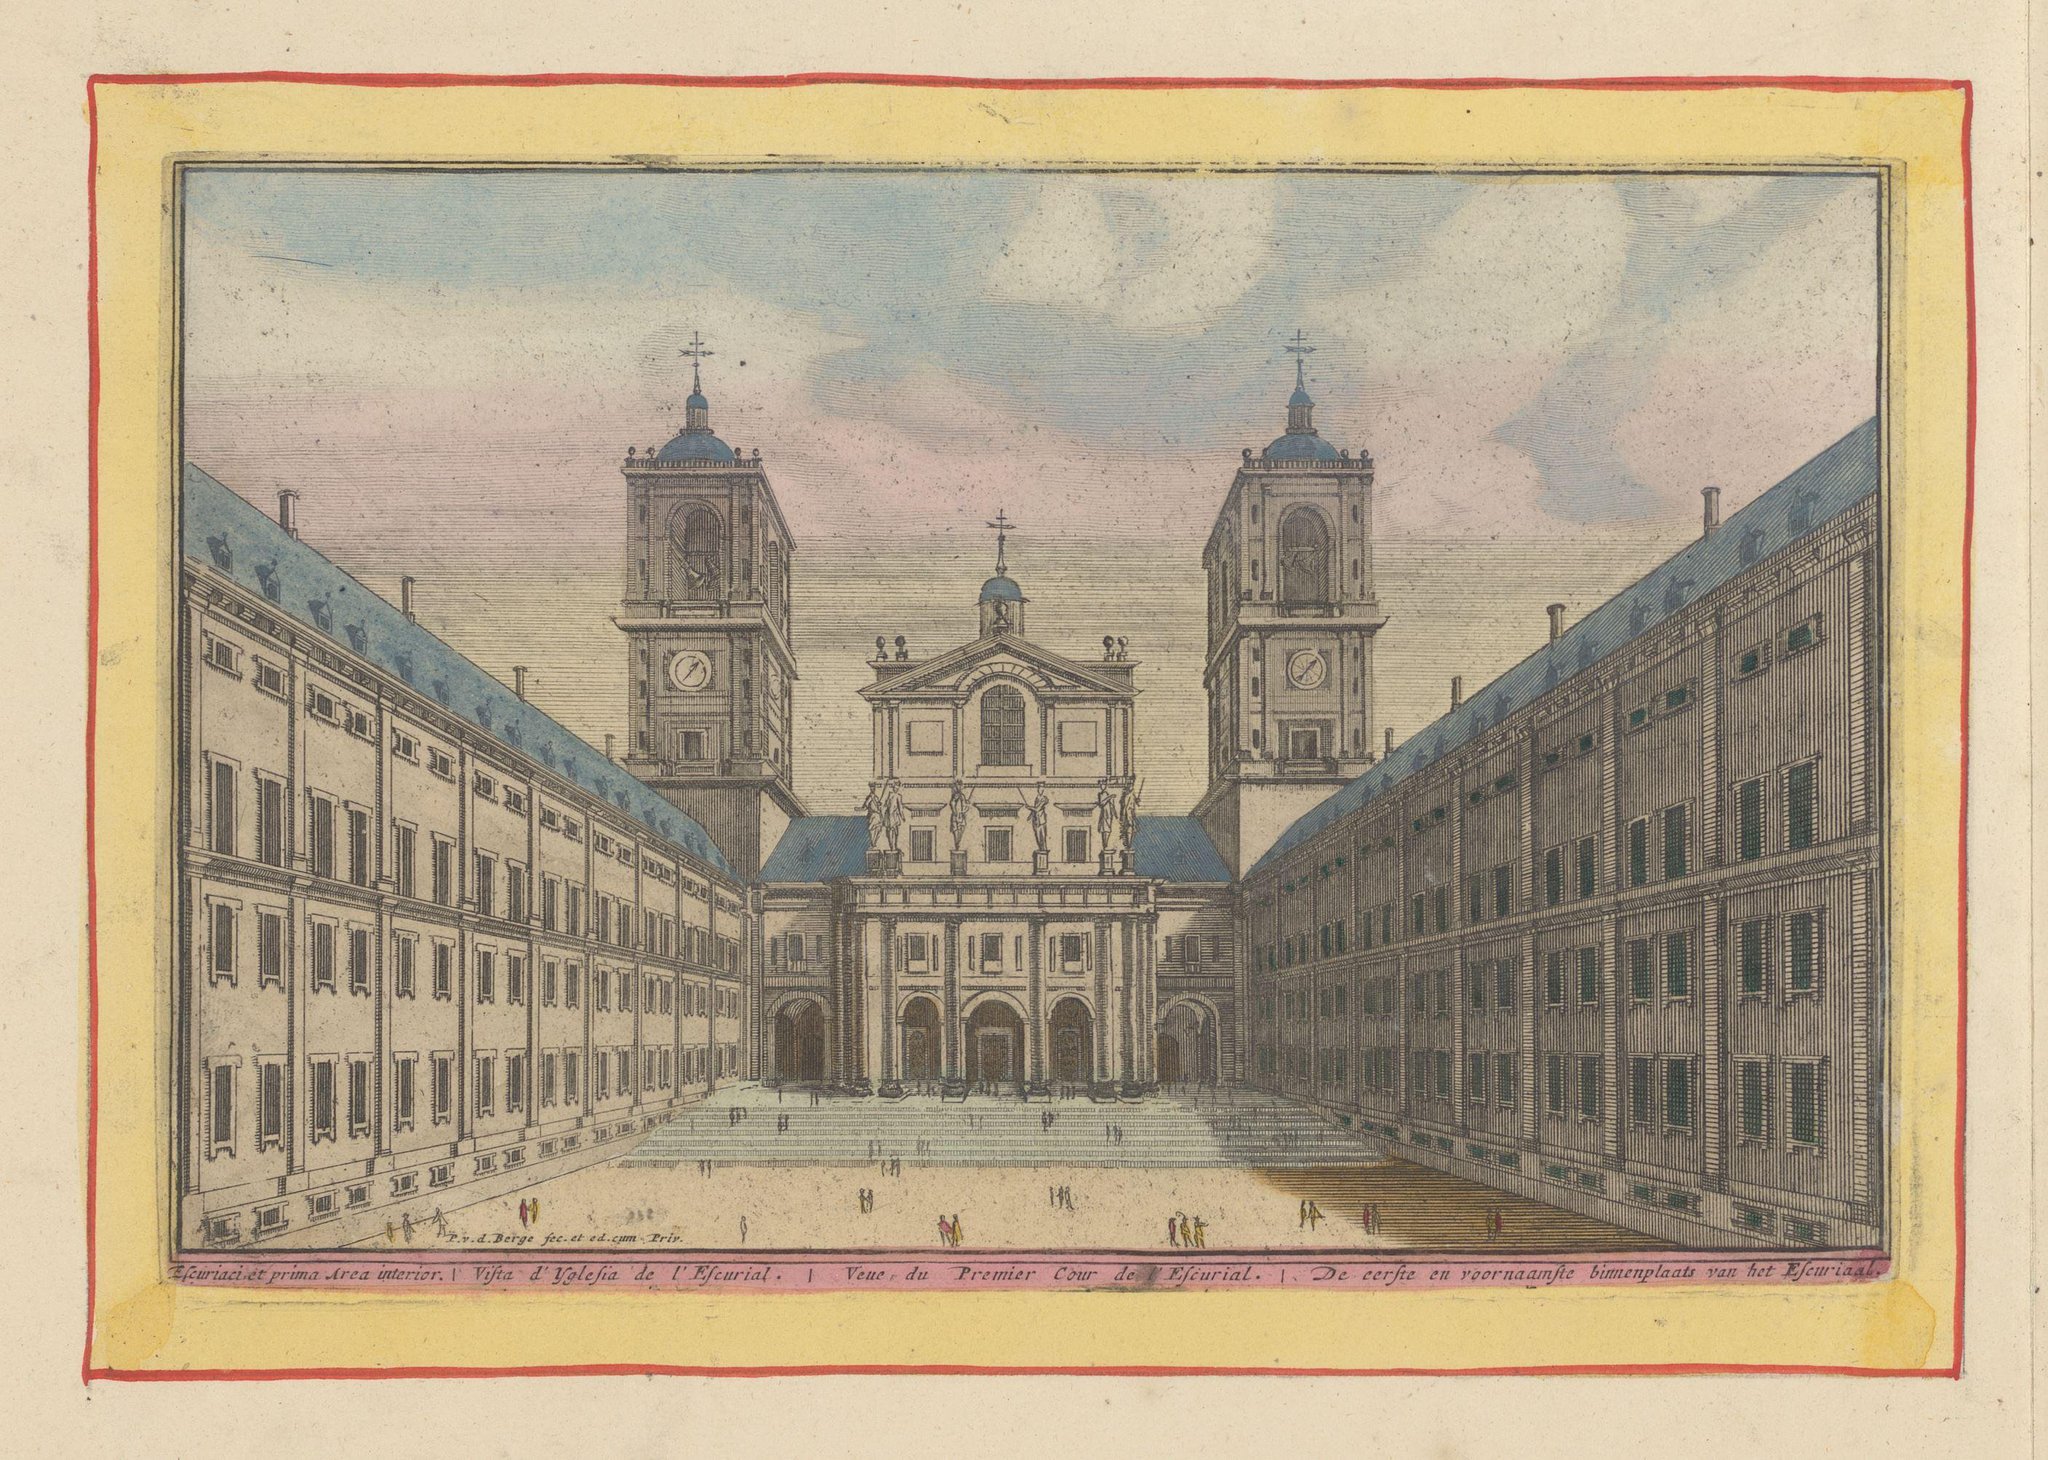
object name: album leaf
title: Gezicht op de binnenplaats en de toegang tot de kerk van San Lorenzo in het Escorial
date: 1694-1737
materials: paper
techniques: etching, hand coloring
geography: amsterdam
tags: abbey, monastery, convent ~ roman catholic church, church (exterior), courtyard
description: Gezicht op de binnenplaats en de toegang tot de kerk van San Lorenzo in het Escorial. Onder de voorstelling een titel in het Latijn, Spaans, Nederlands en Frans. Prent maakt deel uit van een album.